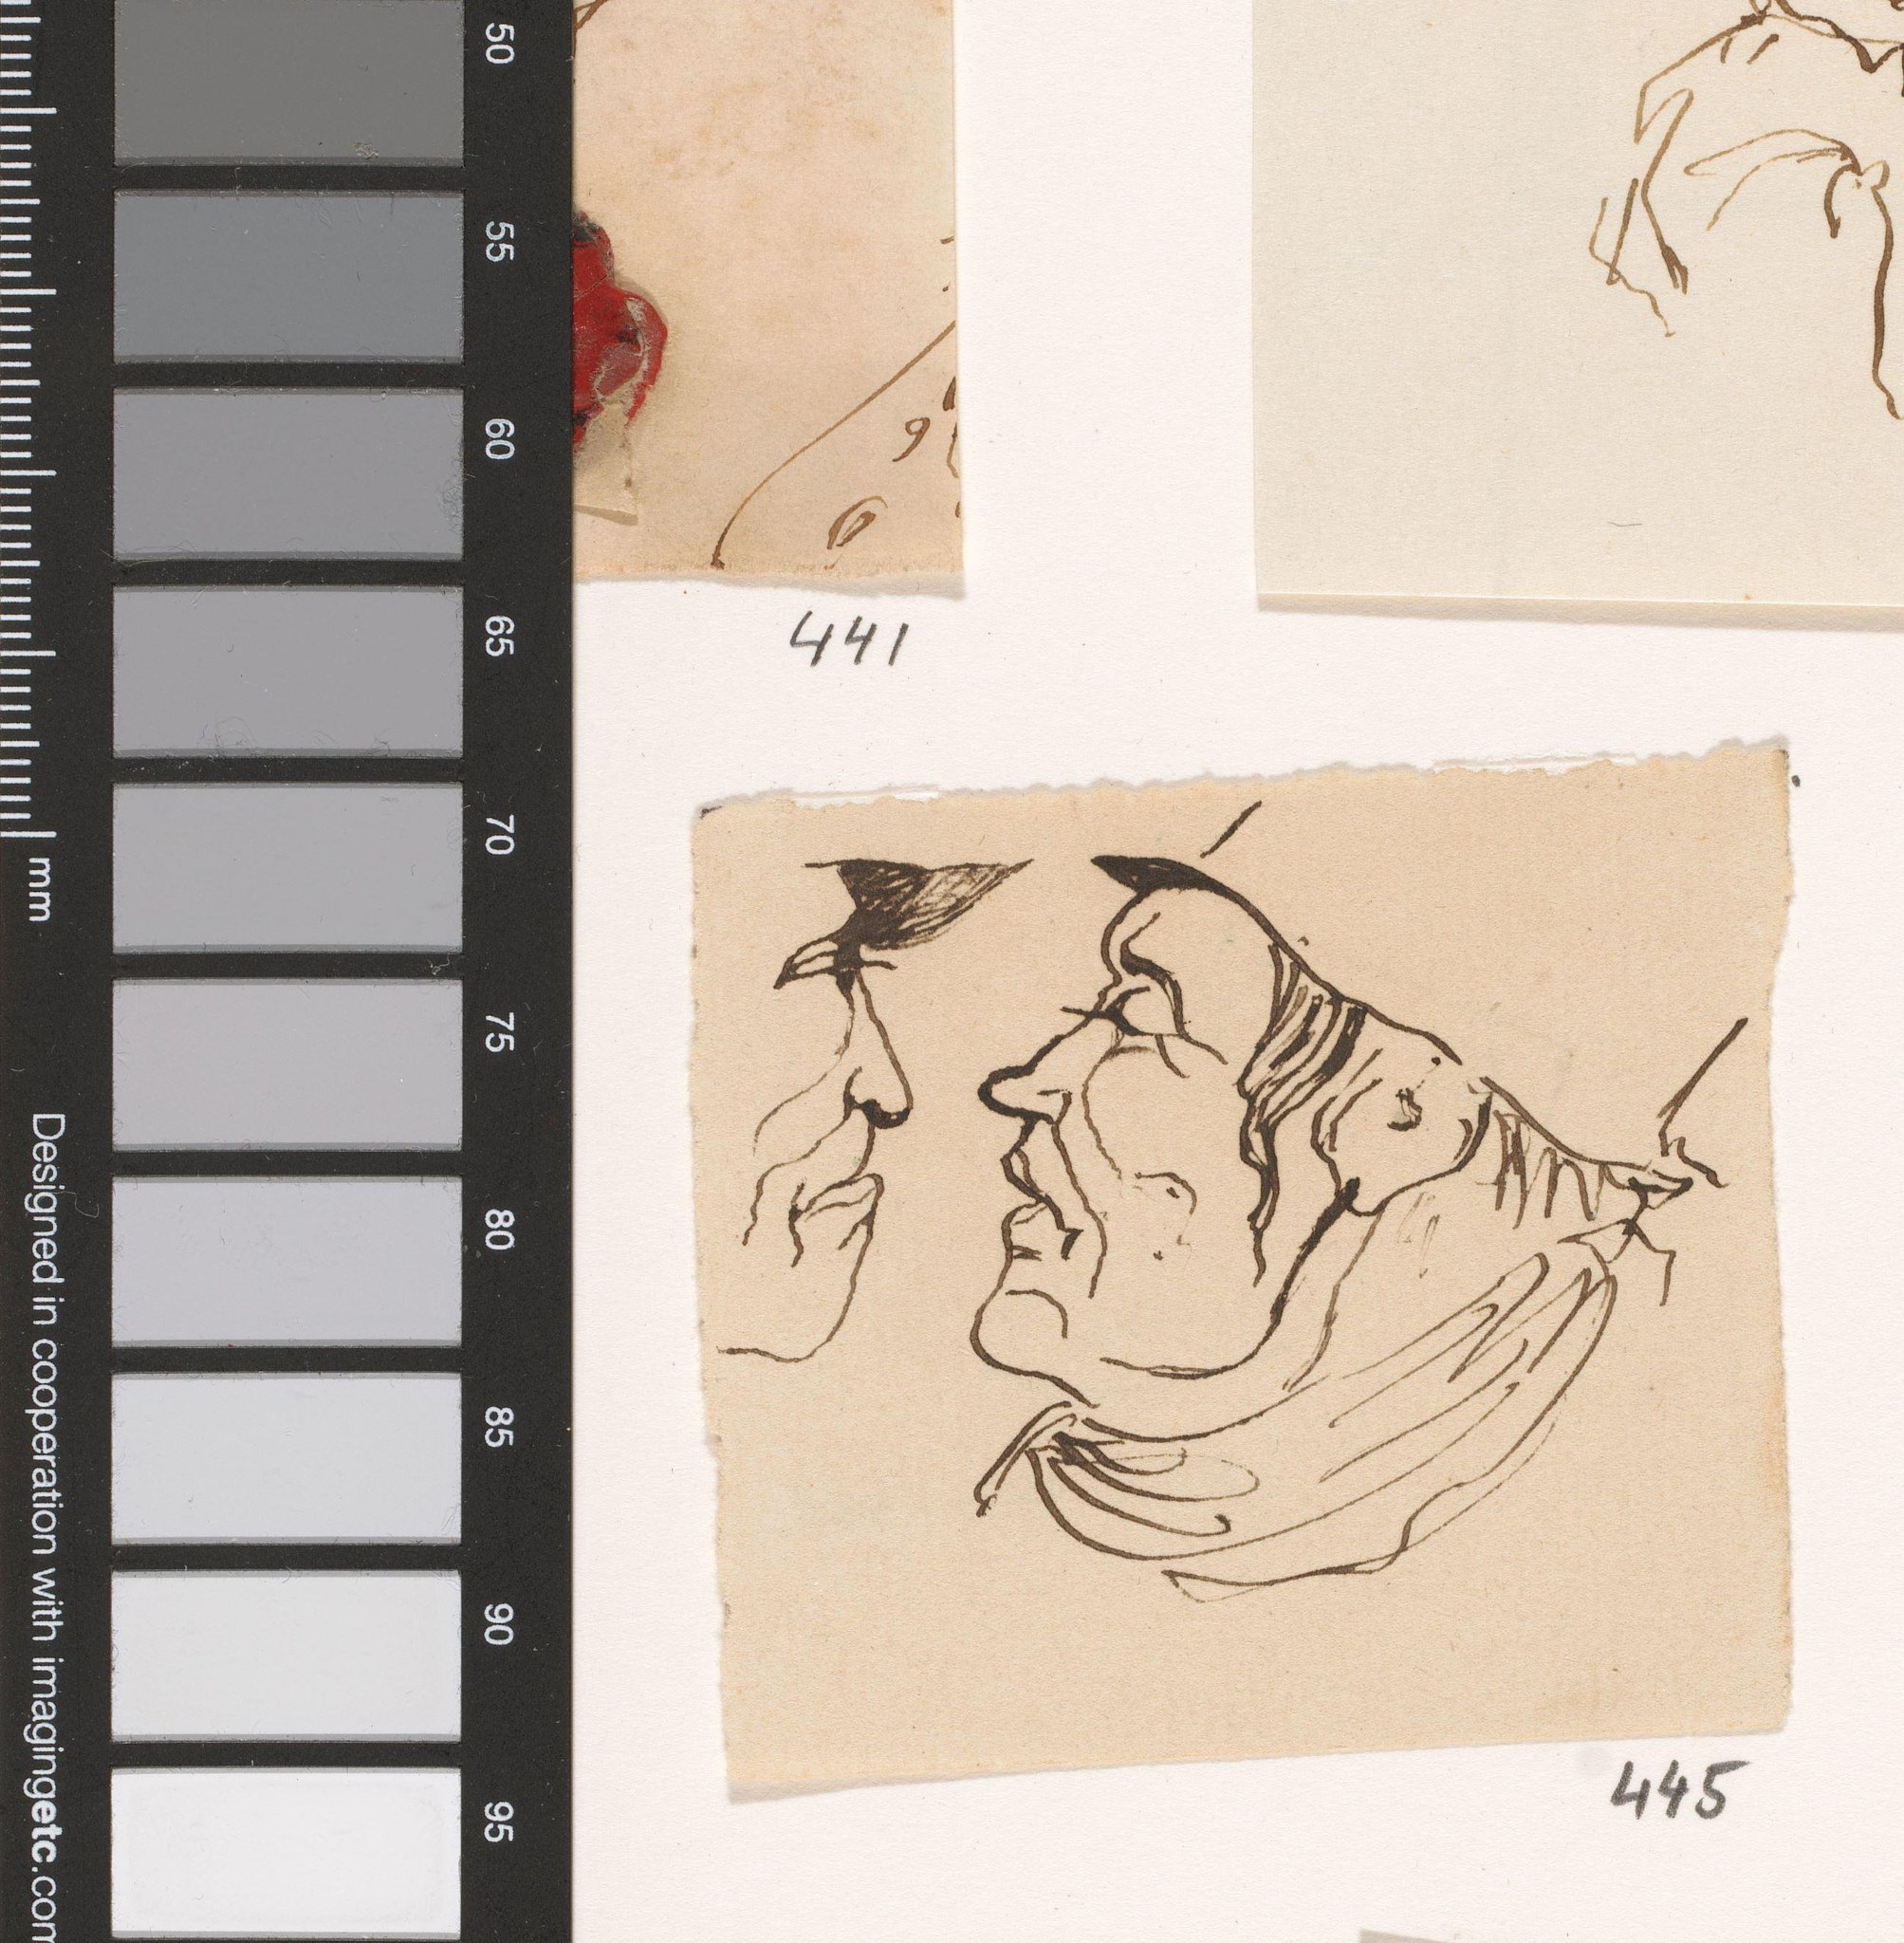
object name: drawing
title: Twee koppen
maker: johannes tavenraat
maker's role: draughtsman, painter, print maker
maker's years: 1809-1881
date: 1840-1880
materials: ink, paper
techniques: pen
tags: caricatures (human types)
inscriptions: collector's mark: Lugt 2228